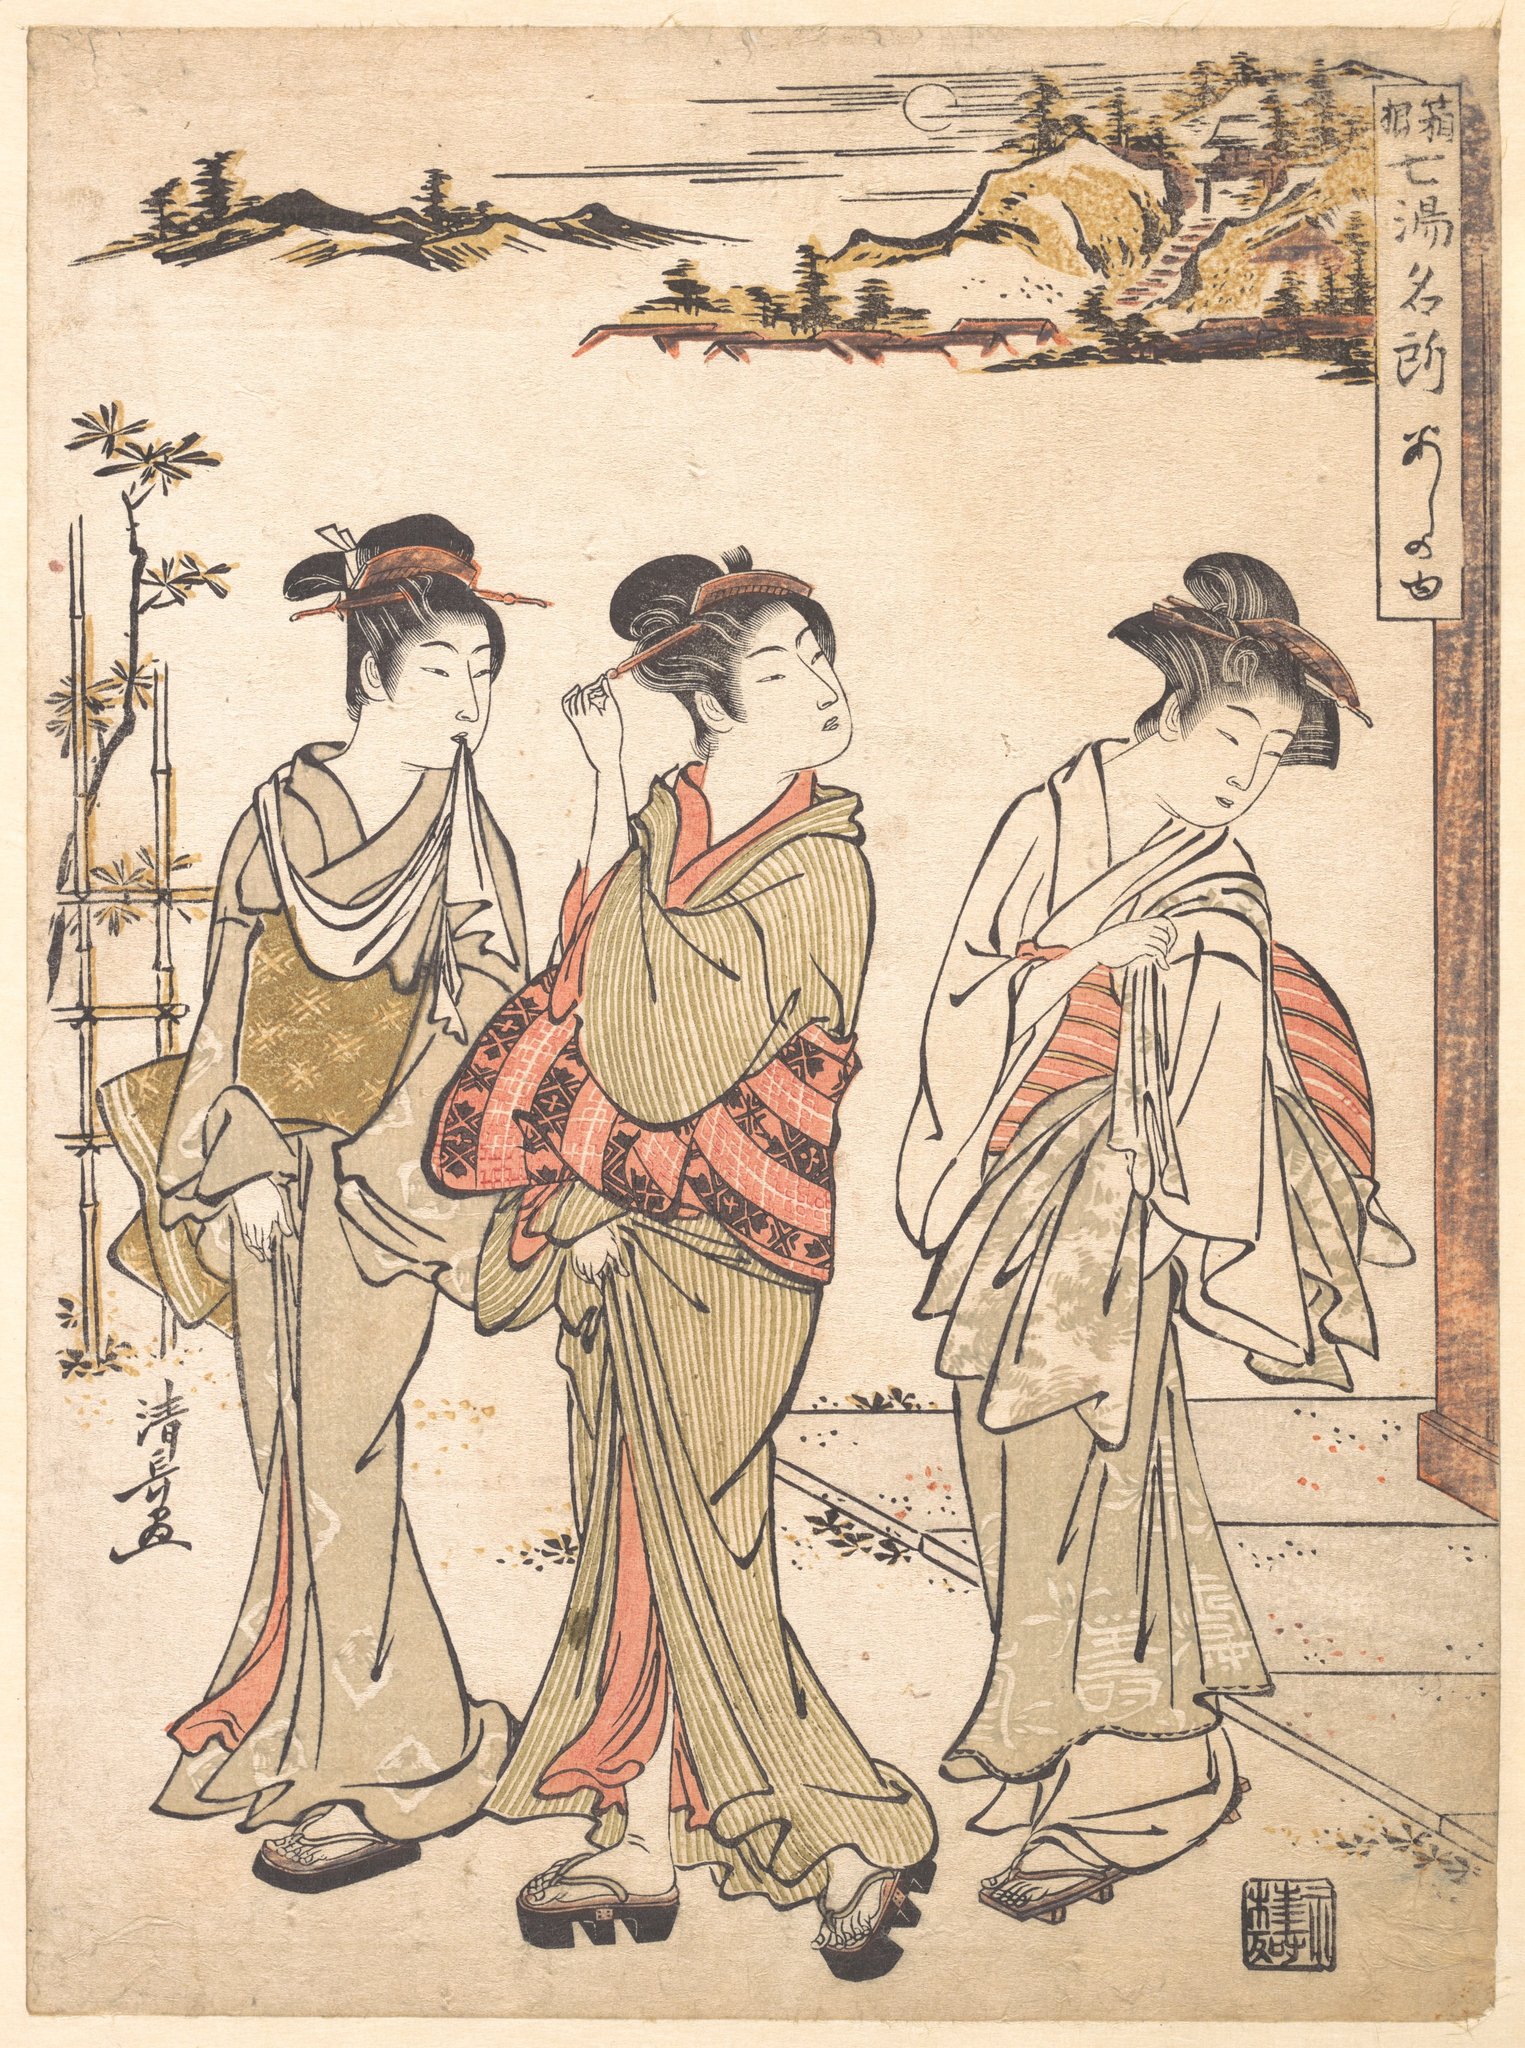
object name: print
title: Ashinoyu Spring in Hakone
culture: japanese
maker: torii kiyonaga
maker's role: artist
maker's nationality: japanese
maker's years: 1752-1815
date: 1779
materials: ink, paper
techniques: woodblock print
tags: women,hills,trees,spring